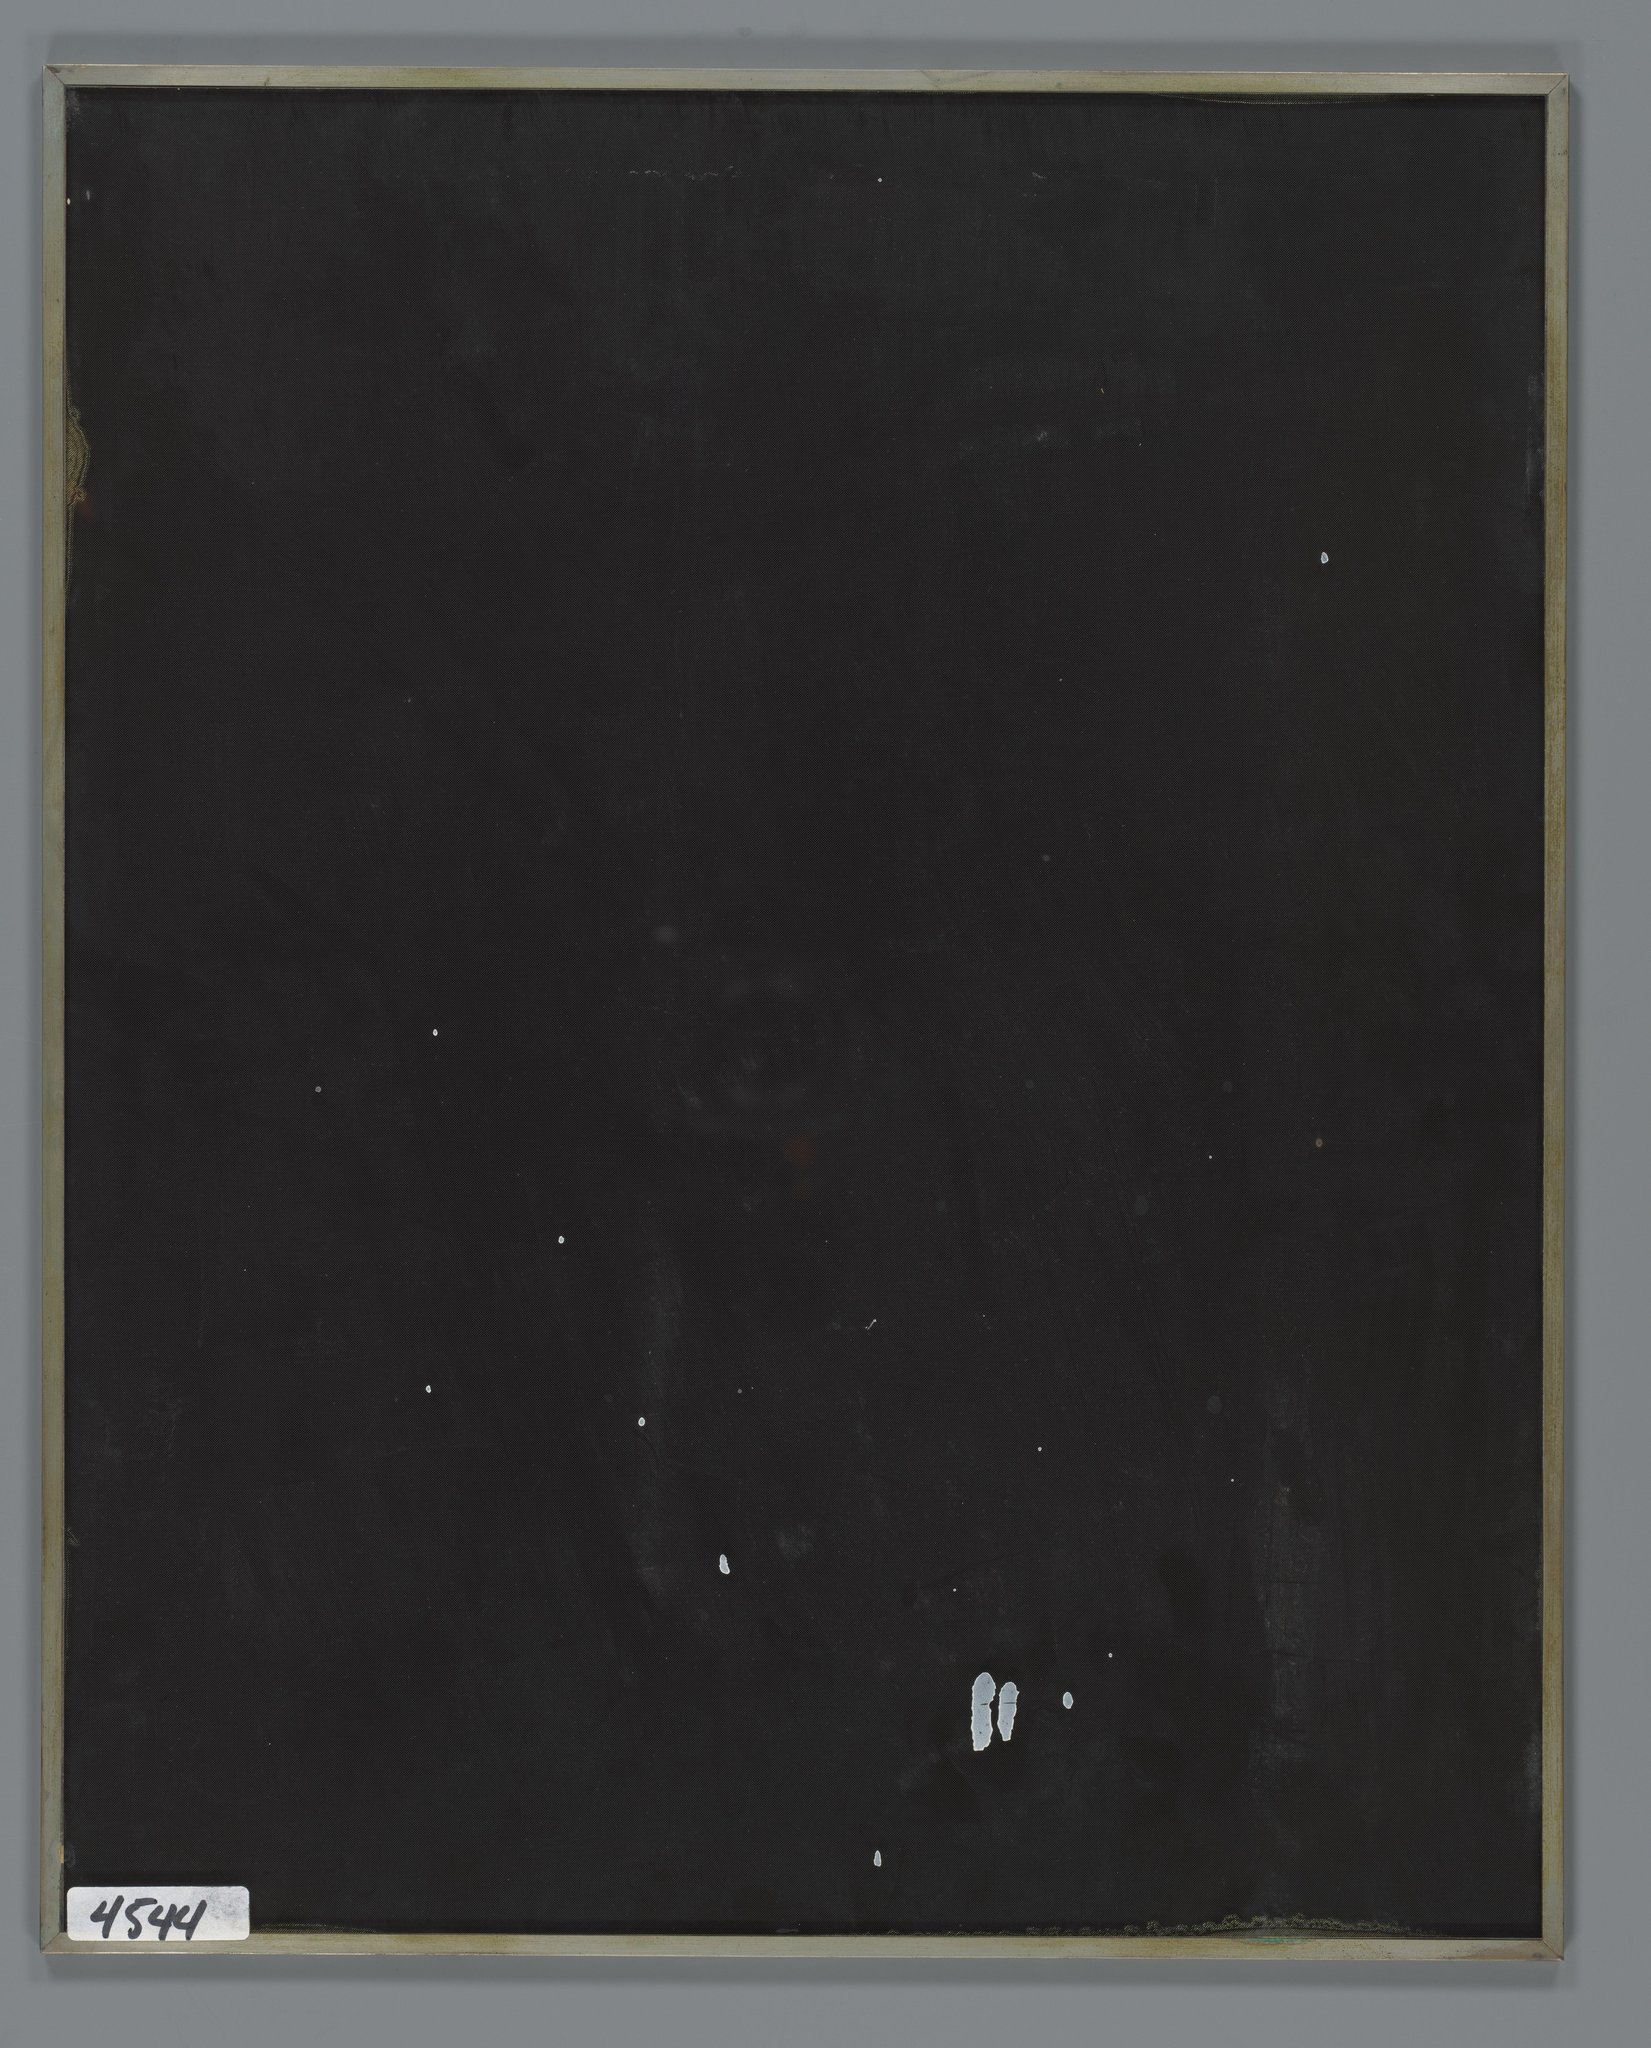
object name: sheet glass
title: Glasplaat voor het maken van autotypieën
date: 1903-1960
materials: glass, metal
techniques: printing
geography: frankfurt am main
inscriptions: inscription: ‘25 Linien per cm Haas-Raster J C Haas Frankfurt a/m No1939 "rep. März 1960" Herbst & Illig Frankfurt a/m 13’